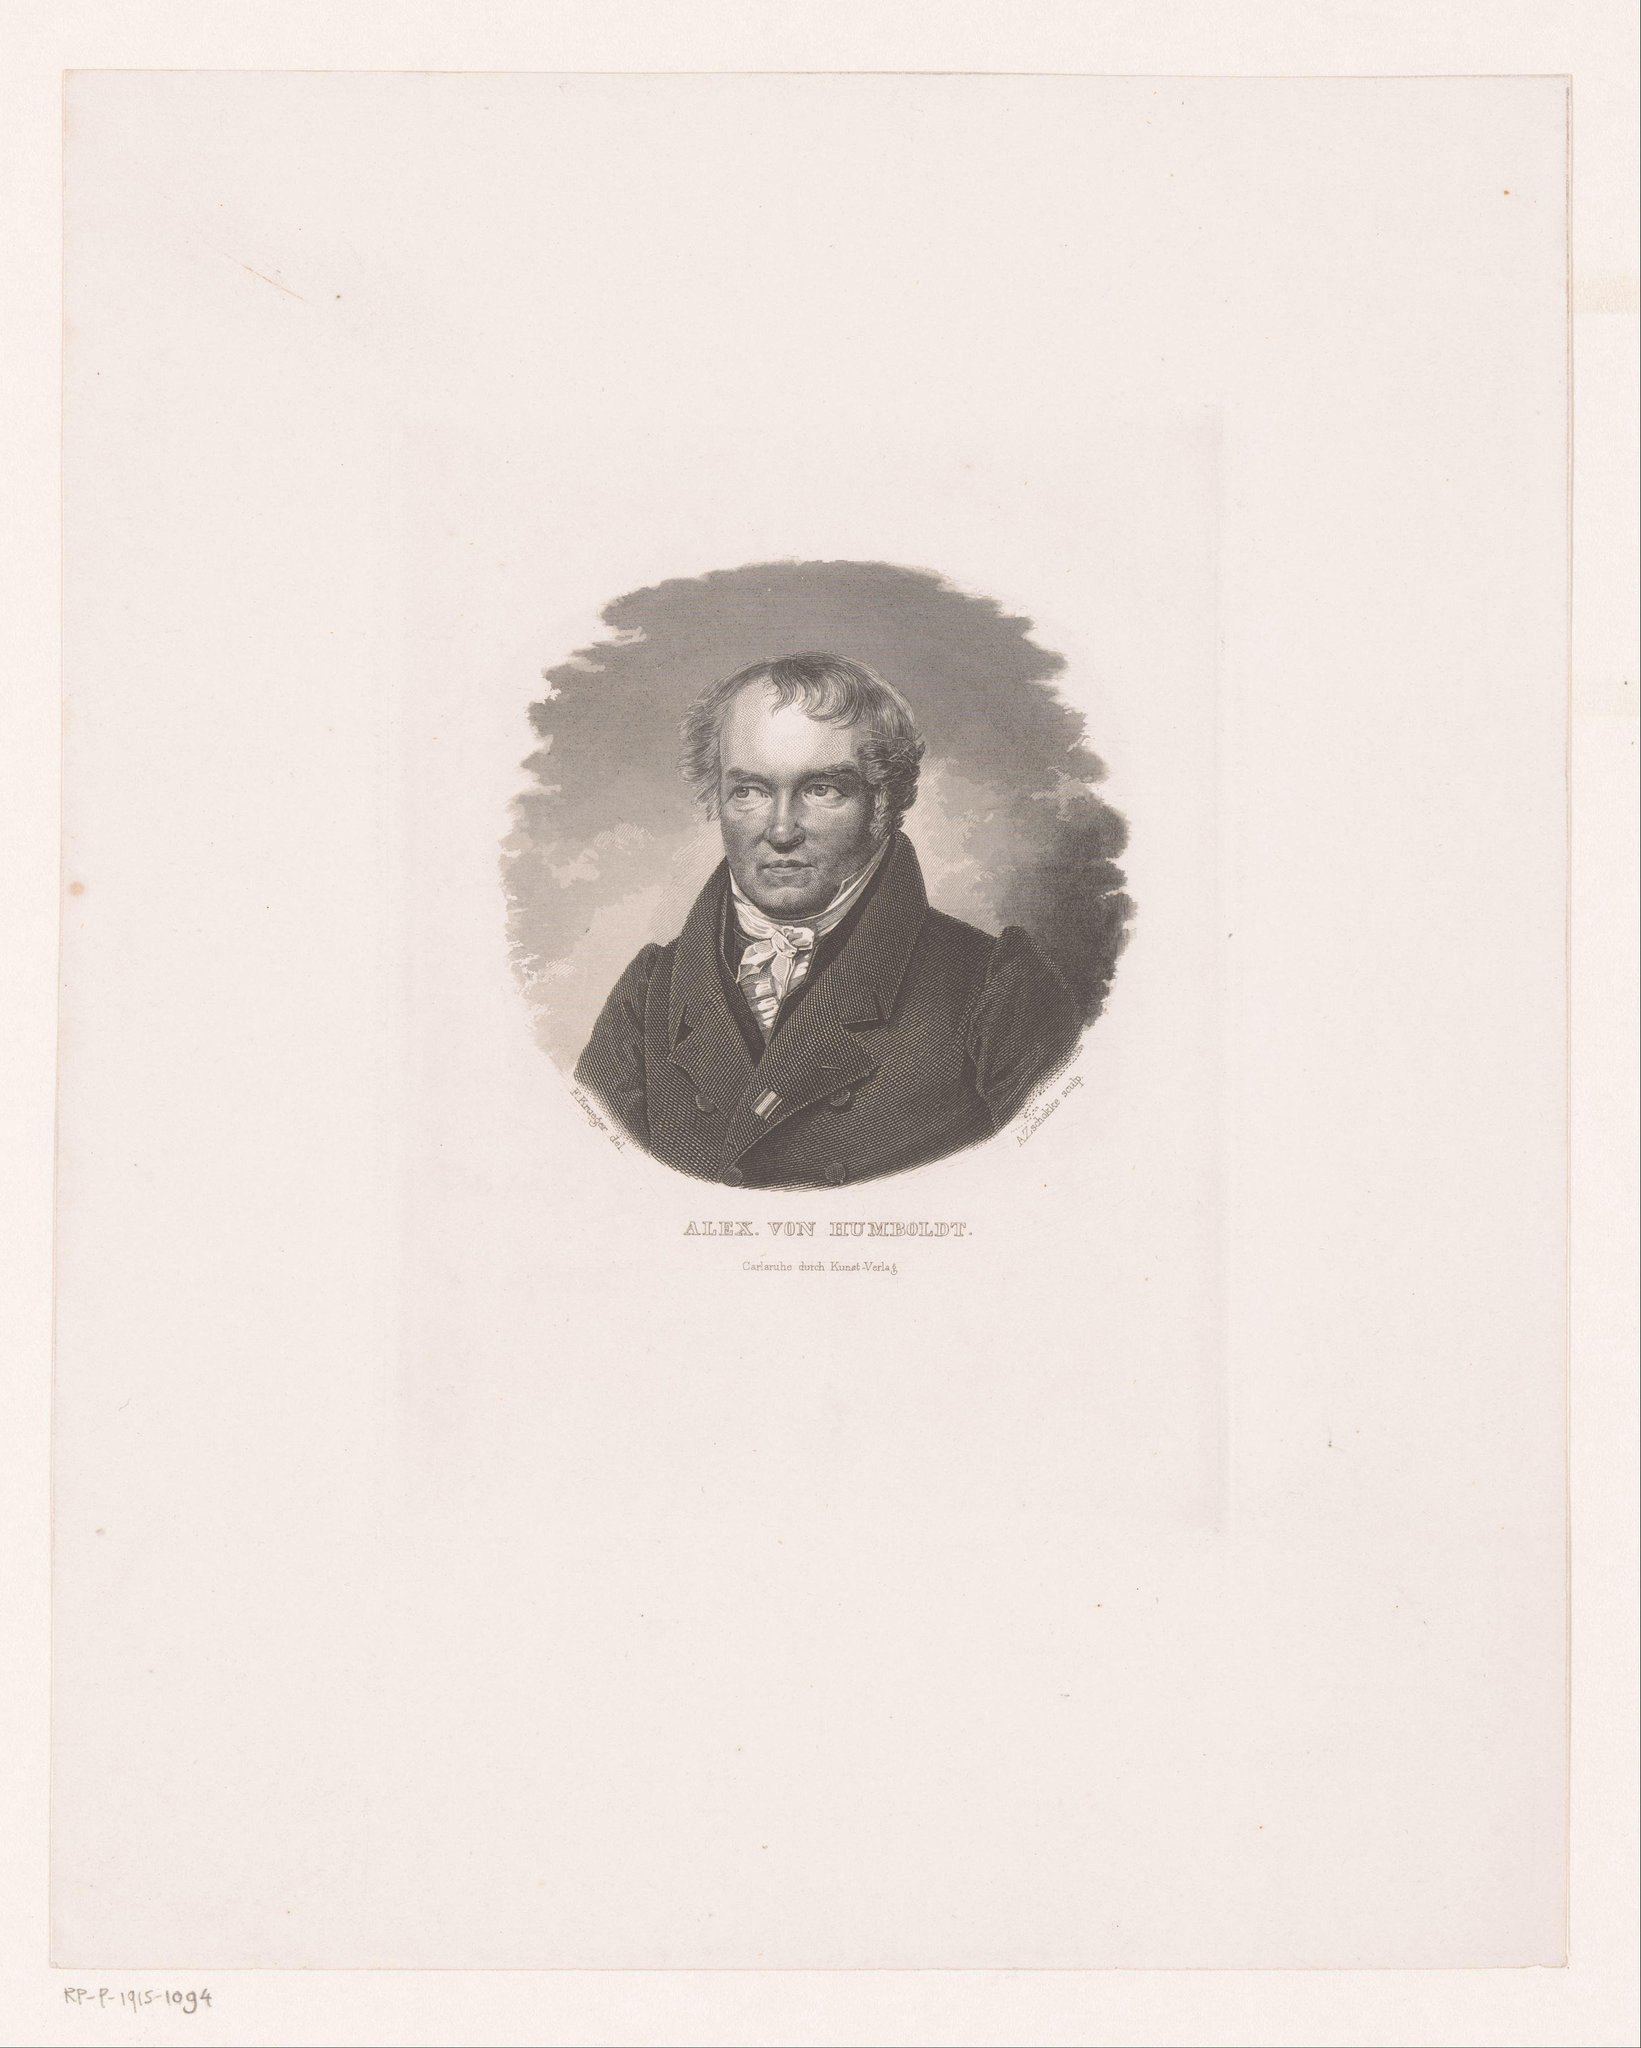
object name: print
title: Portret van Alexander von Humboldt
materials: paper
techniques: engraving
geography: karlsruhe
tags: berlin, traveler, historical persons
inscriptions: collector's mark: Lugt 2228